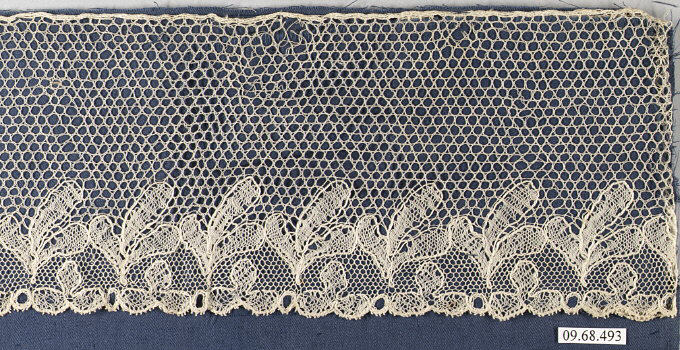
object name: fragment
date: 1801-1900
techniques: lace